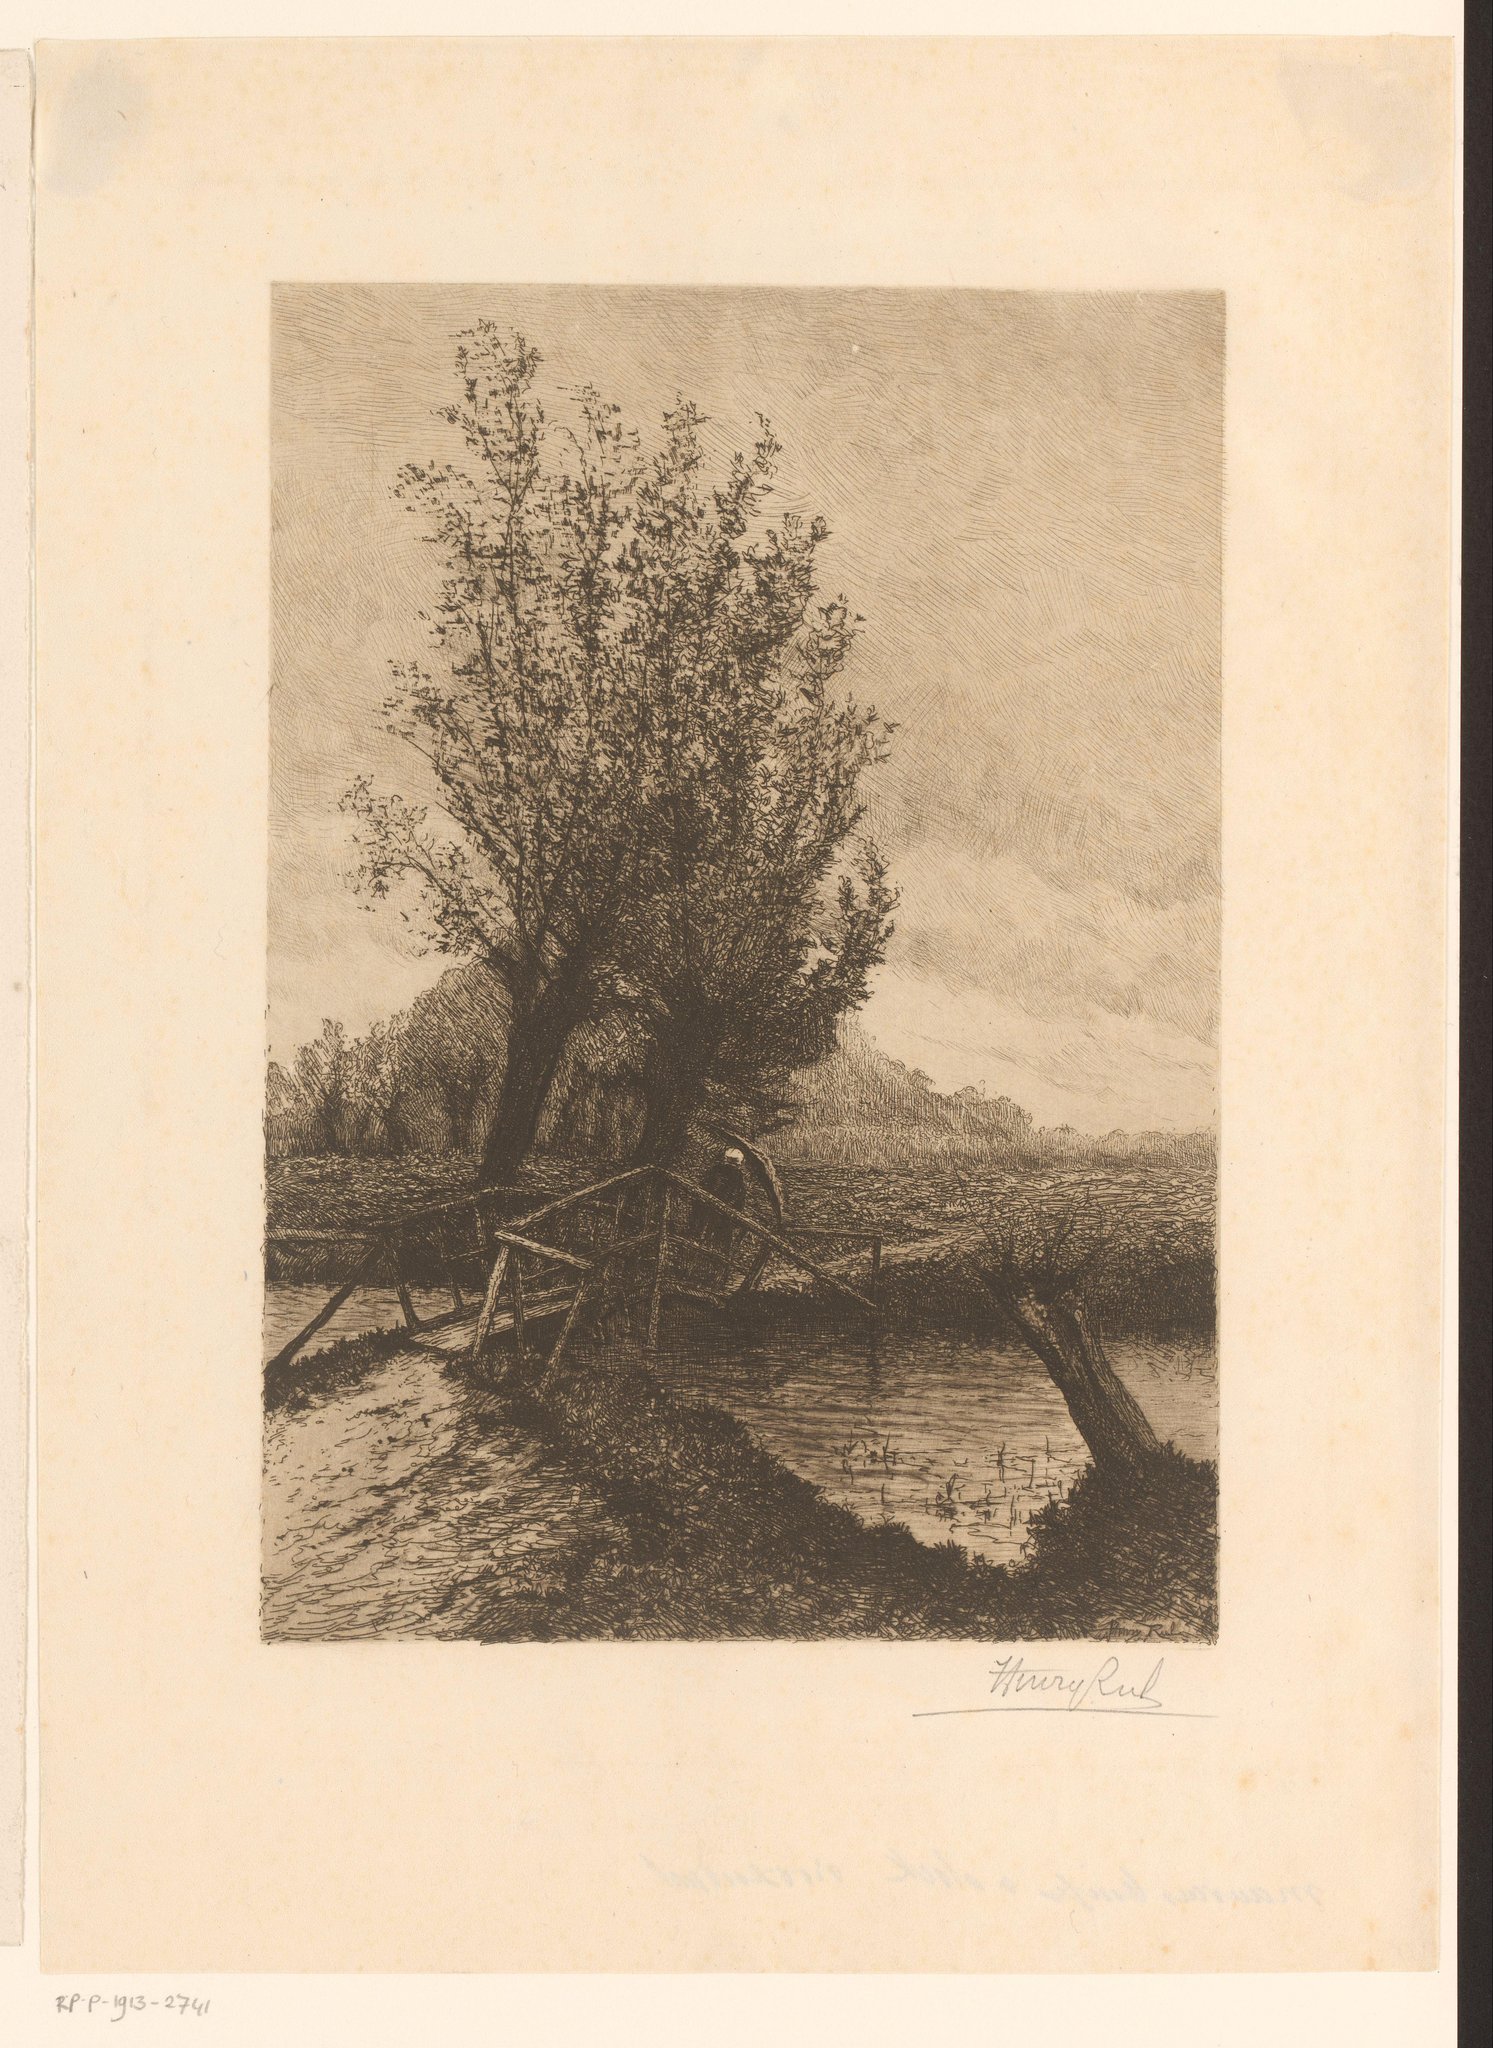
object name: print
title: Figuur met paraplu loopt over een brug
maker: henri rul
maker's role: print maker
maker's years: 1862-1942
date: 1872-1913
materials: paper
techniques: drypoint, etching, retroussage, roulette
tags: landscapes with waters, waterscapes, seascapes (in the temperate zone), umbrella, bridge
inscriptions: mark: ‘Antwerpsche Etsers 1880’, collector's mark: Lugt 2228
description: Mogelijk gaat het om een gezicht op De Stok te Roosendaal. In de inventaris getiteld: Herinnering aan Stock Roosendaal.